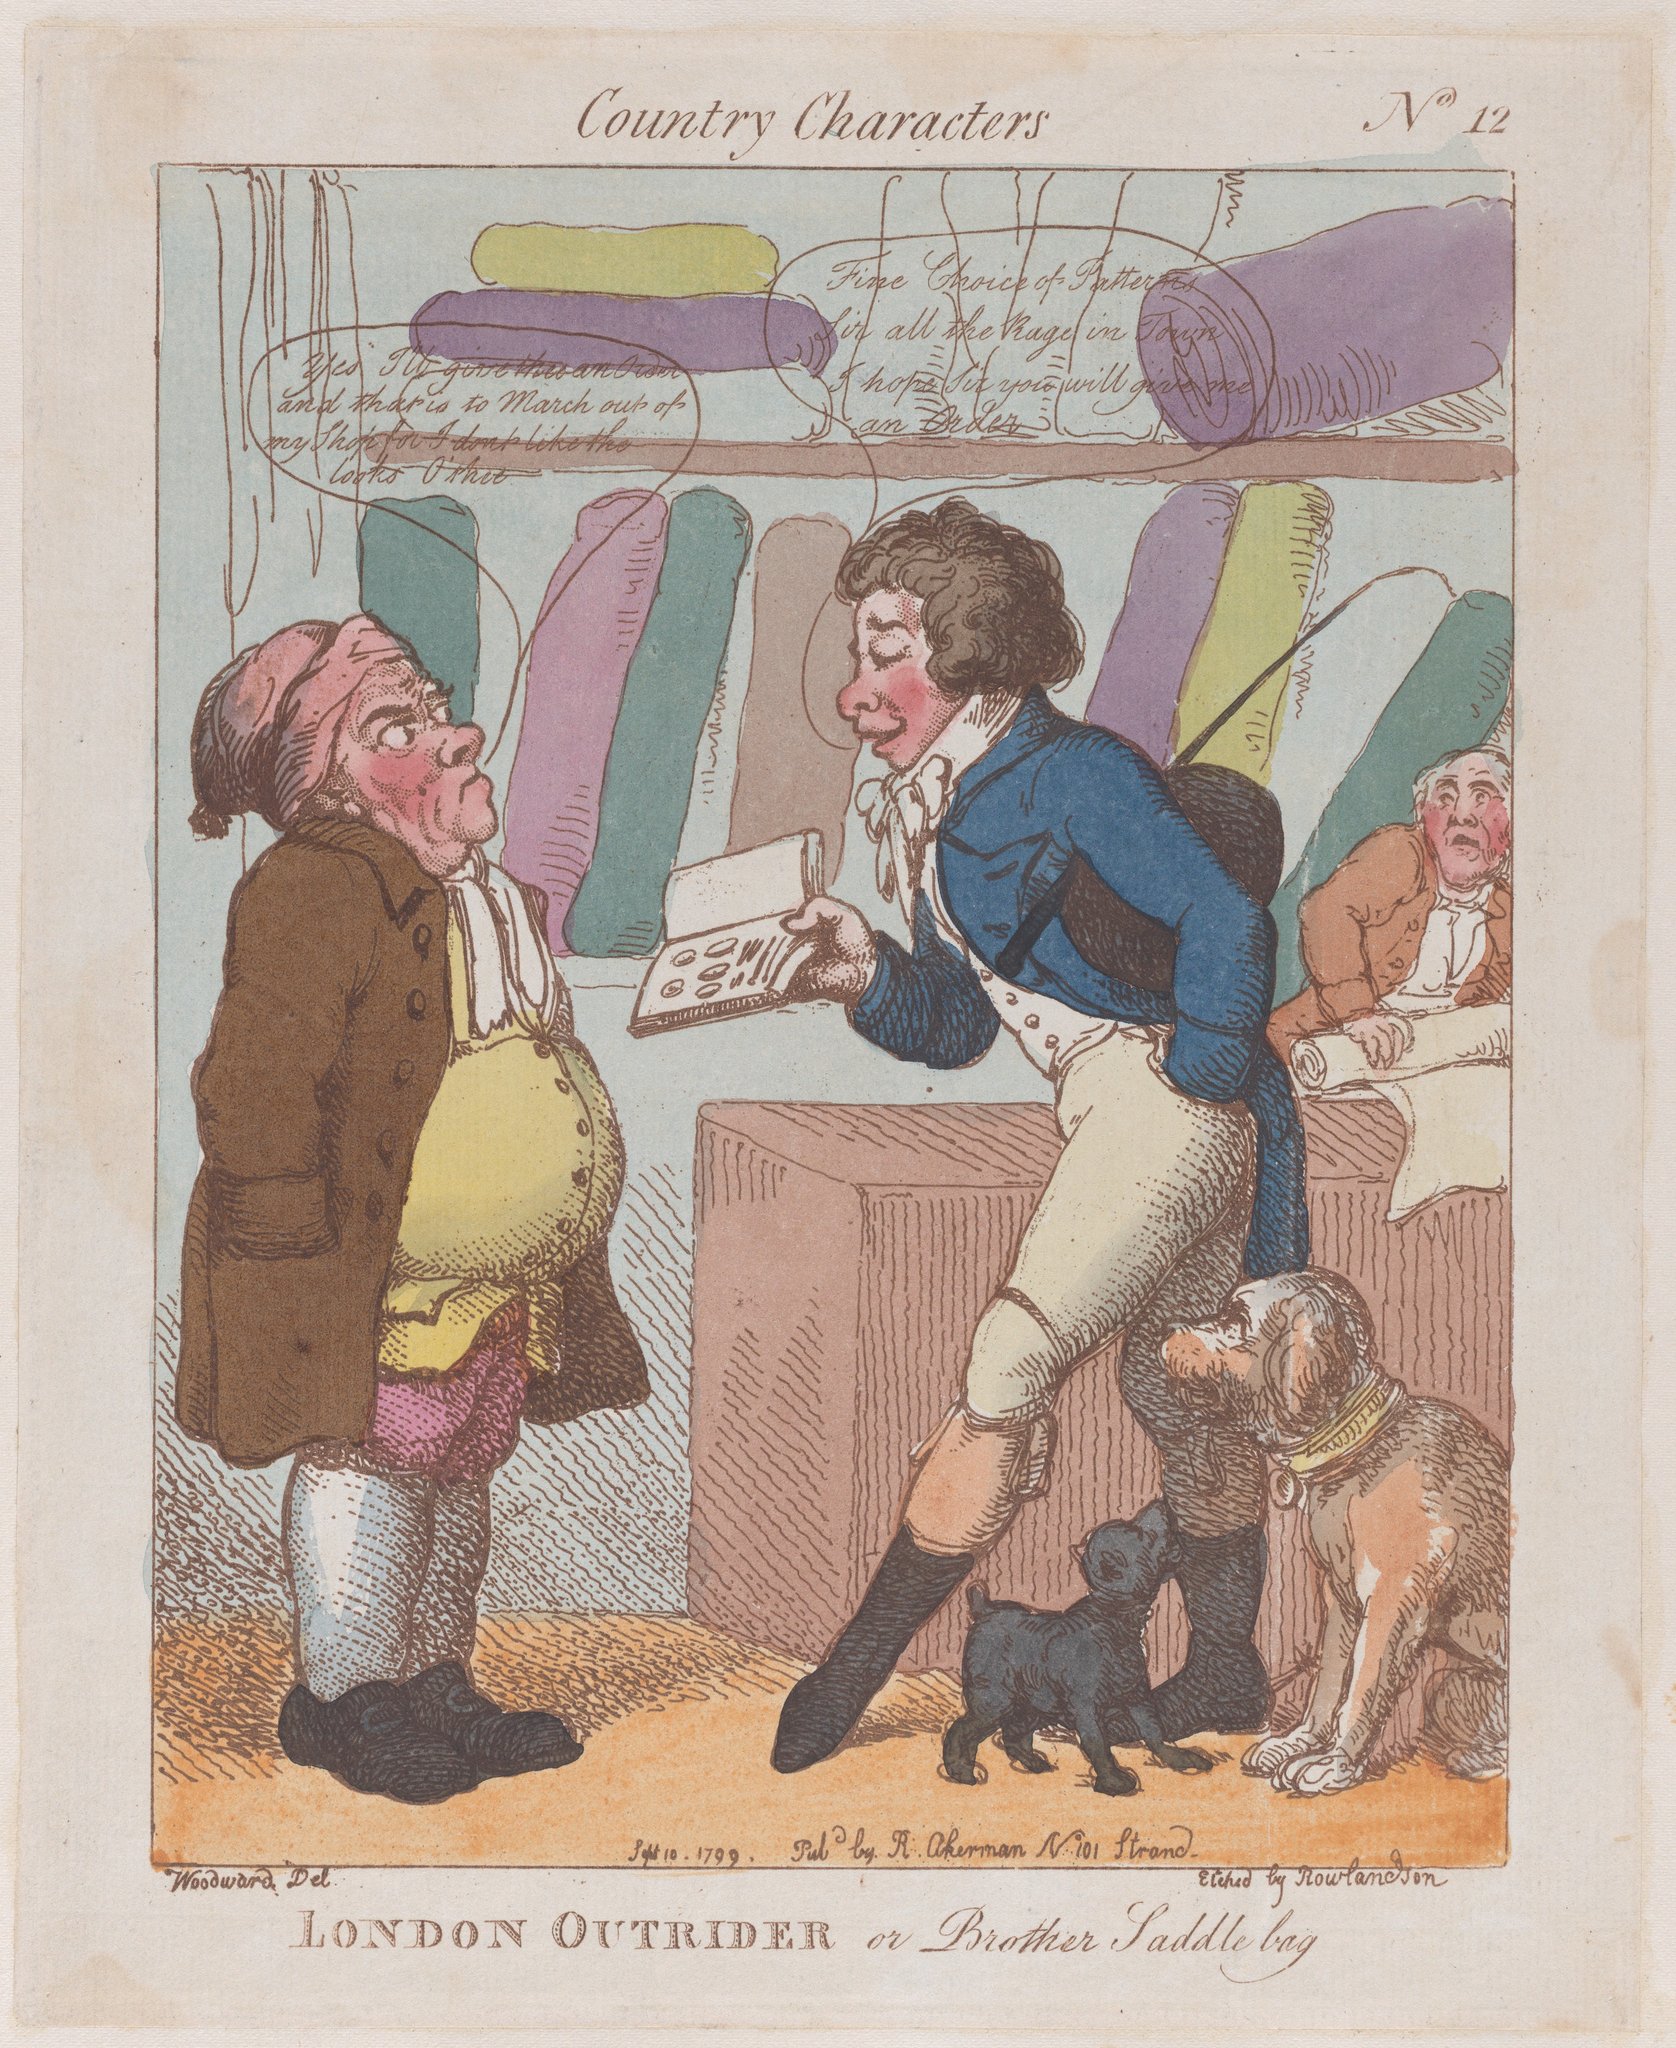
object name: print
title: London Outrider, or Brother Saddlebag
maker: thomas rowlandson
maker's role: artist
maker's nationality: british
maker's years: 1757-1827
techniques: etching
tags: satire,men,dogs